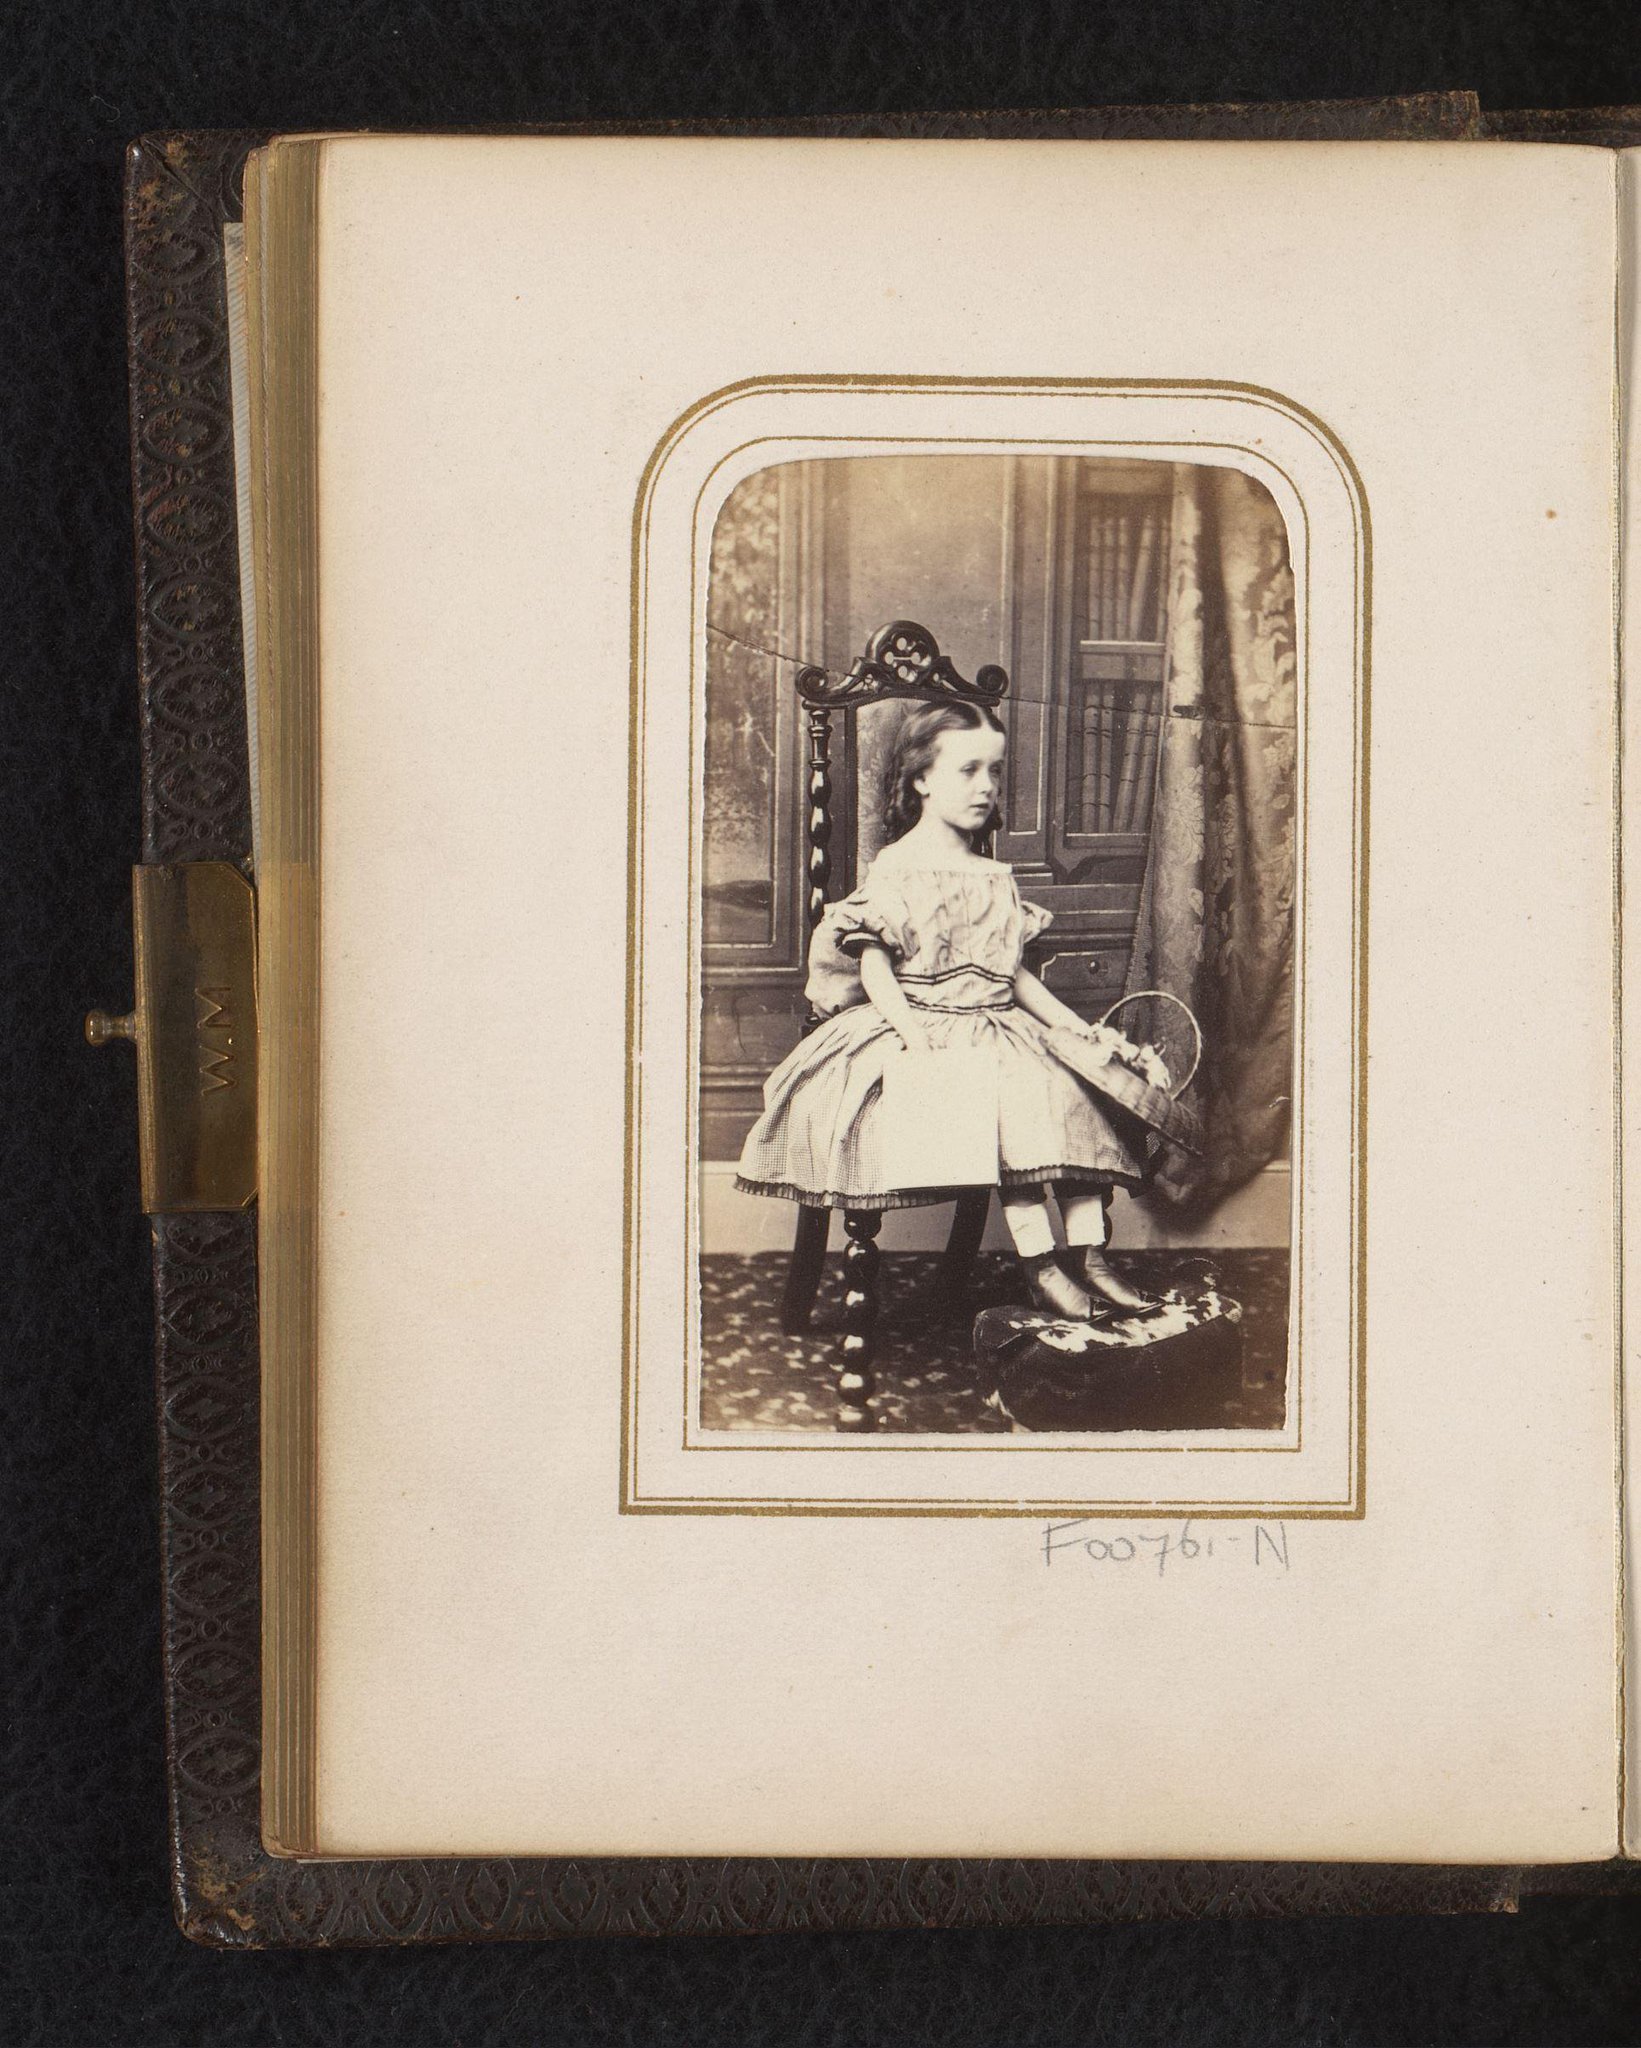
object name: carte de visite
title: Portret van een meisje, zittend met een mand en boek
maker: Anonymous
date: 1860-1880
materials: cardboard, photographic support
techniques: albumen print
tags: girl (child between toddler and youth)